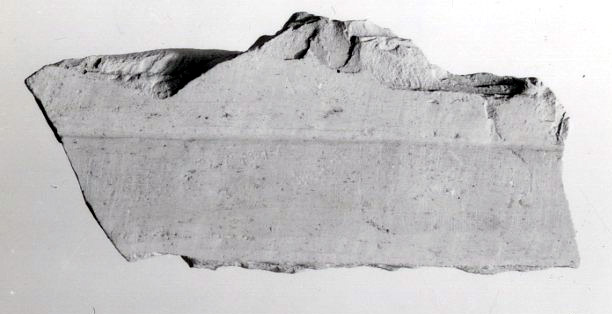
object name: relief fragment, tomb of meketre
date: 1981-1975 BCE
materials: limestone, paint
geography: egypt